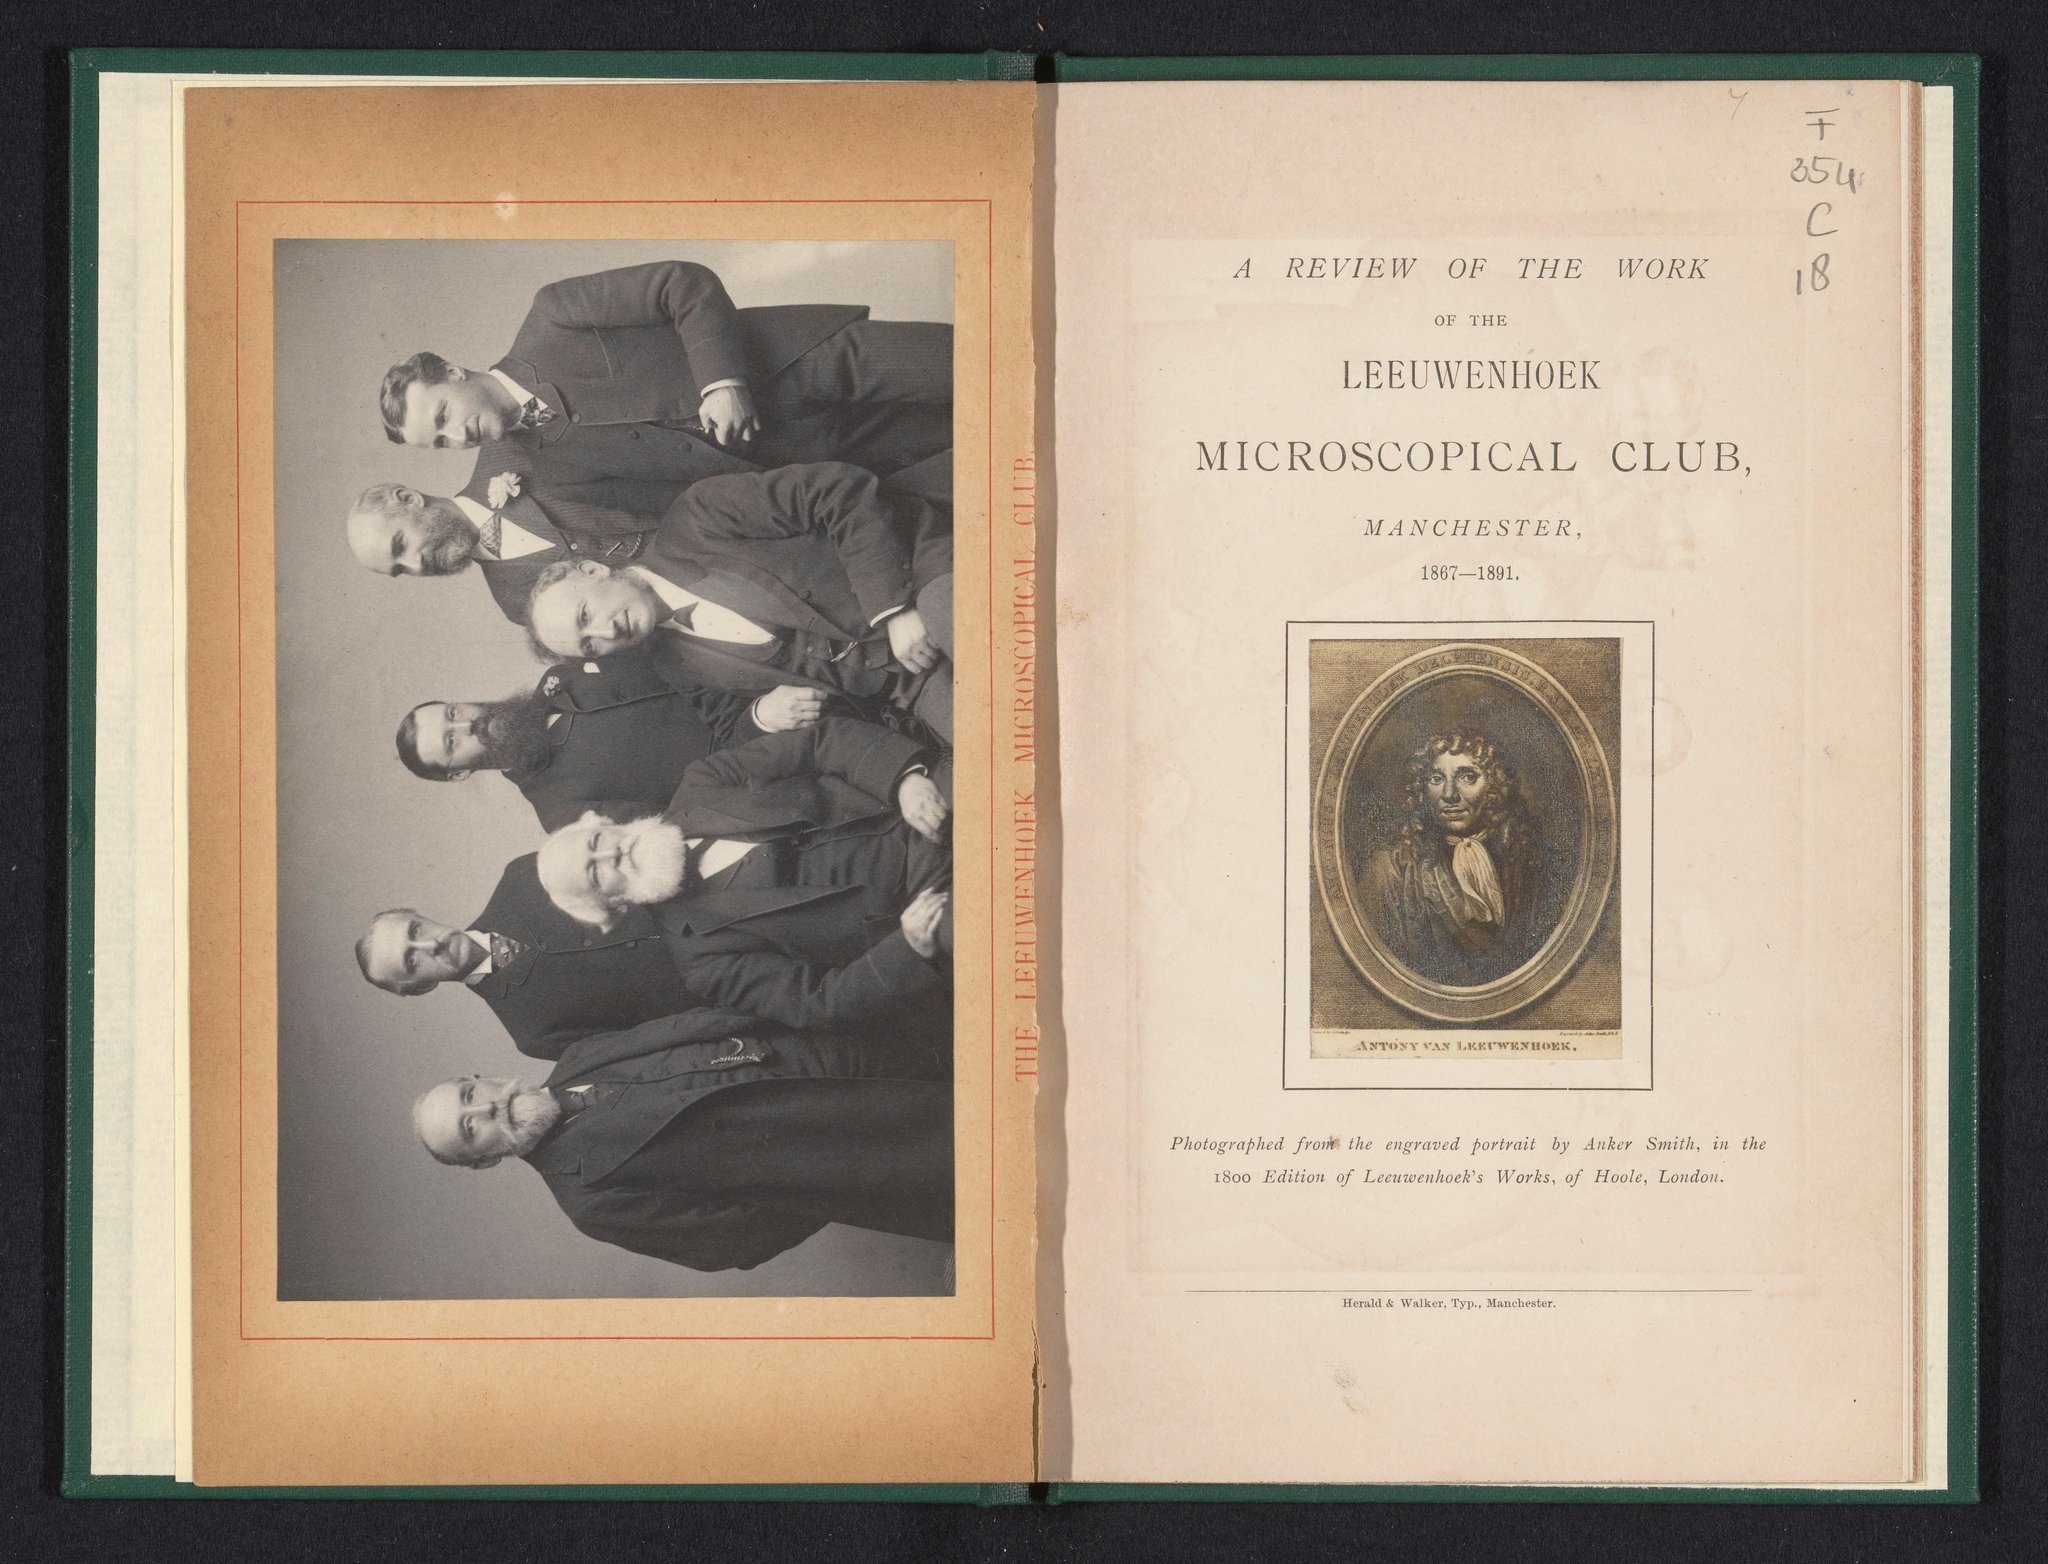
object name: reproduction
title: Fotoreproductie van een prent door Anker Smith, voorstellend een portret van Anthony van Leeuwenhoek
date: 1881-1891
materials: photographic support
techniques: gelatin silver print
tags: delft, physicist, anthony van leeuwenhoek, print, e.g.: engraving, etching, lithograph